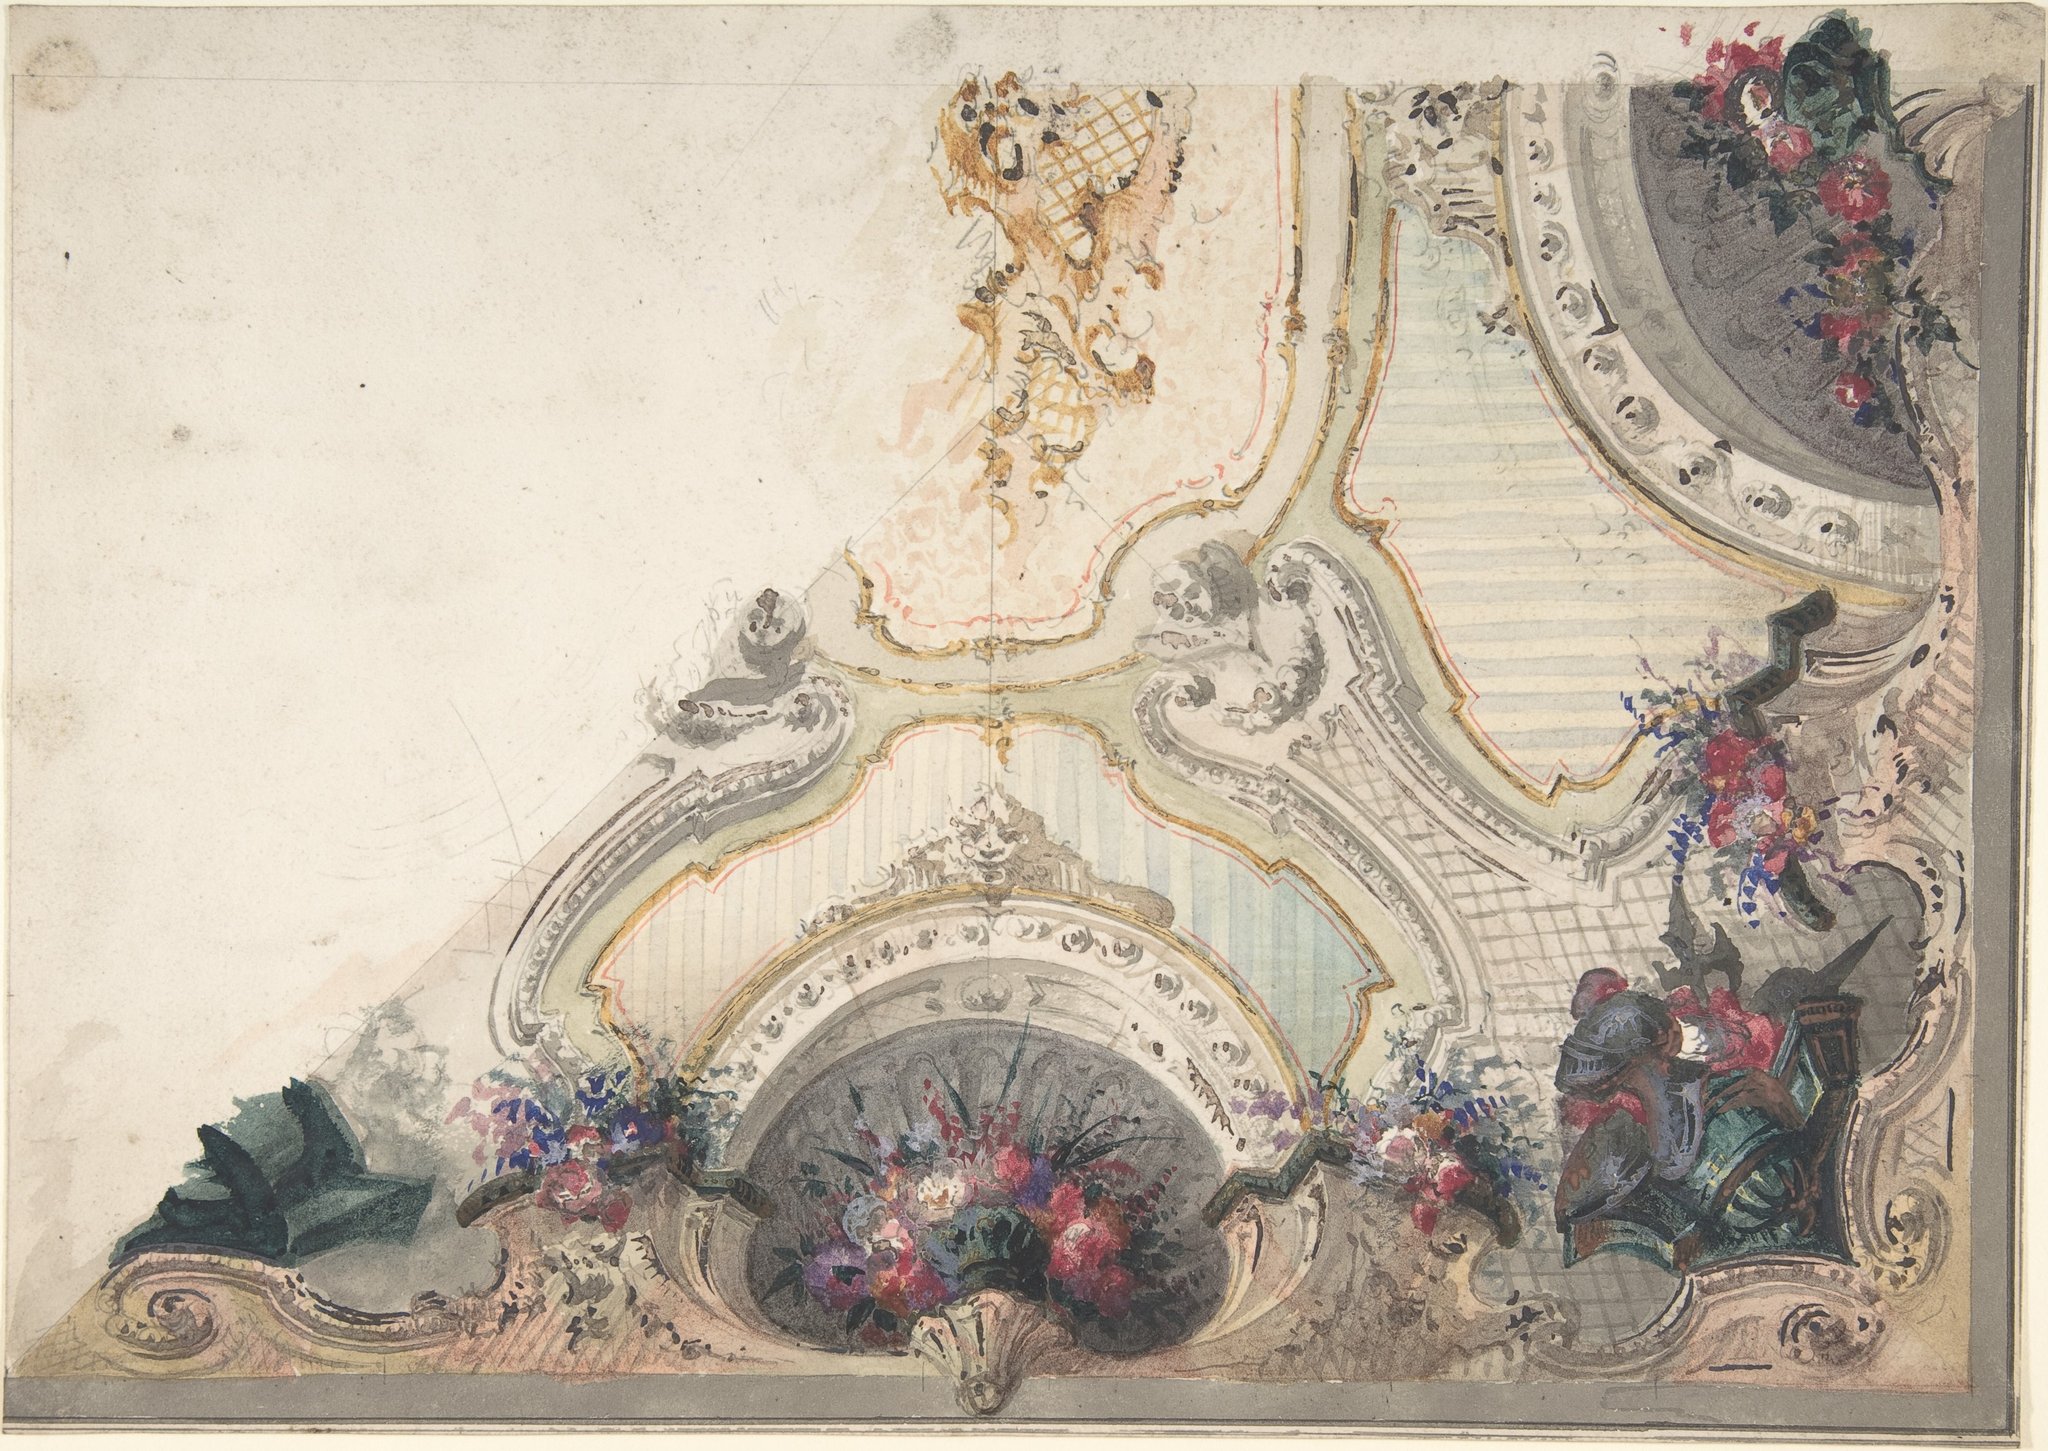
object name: drawing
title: Design for a Painted Ceiling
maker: anonymous, italian, 19th century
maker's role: artist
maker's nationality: italian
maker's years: 1800-1900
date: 1800-1900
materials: watercolor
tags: flowers,ceilings